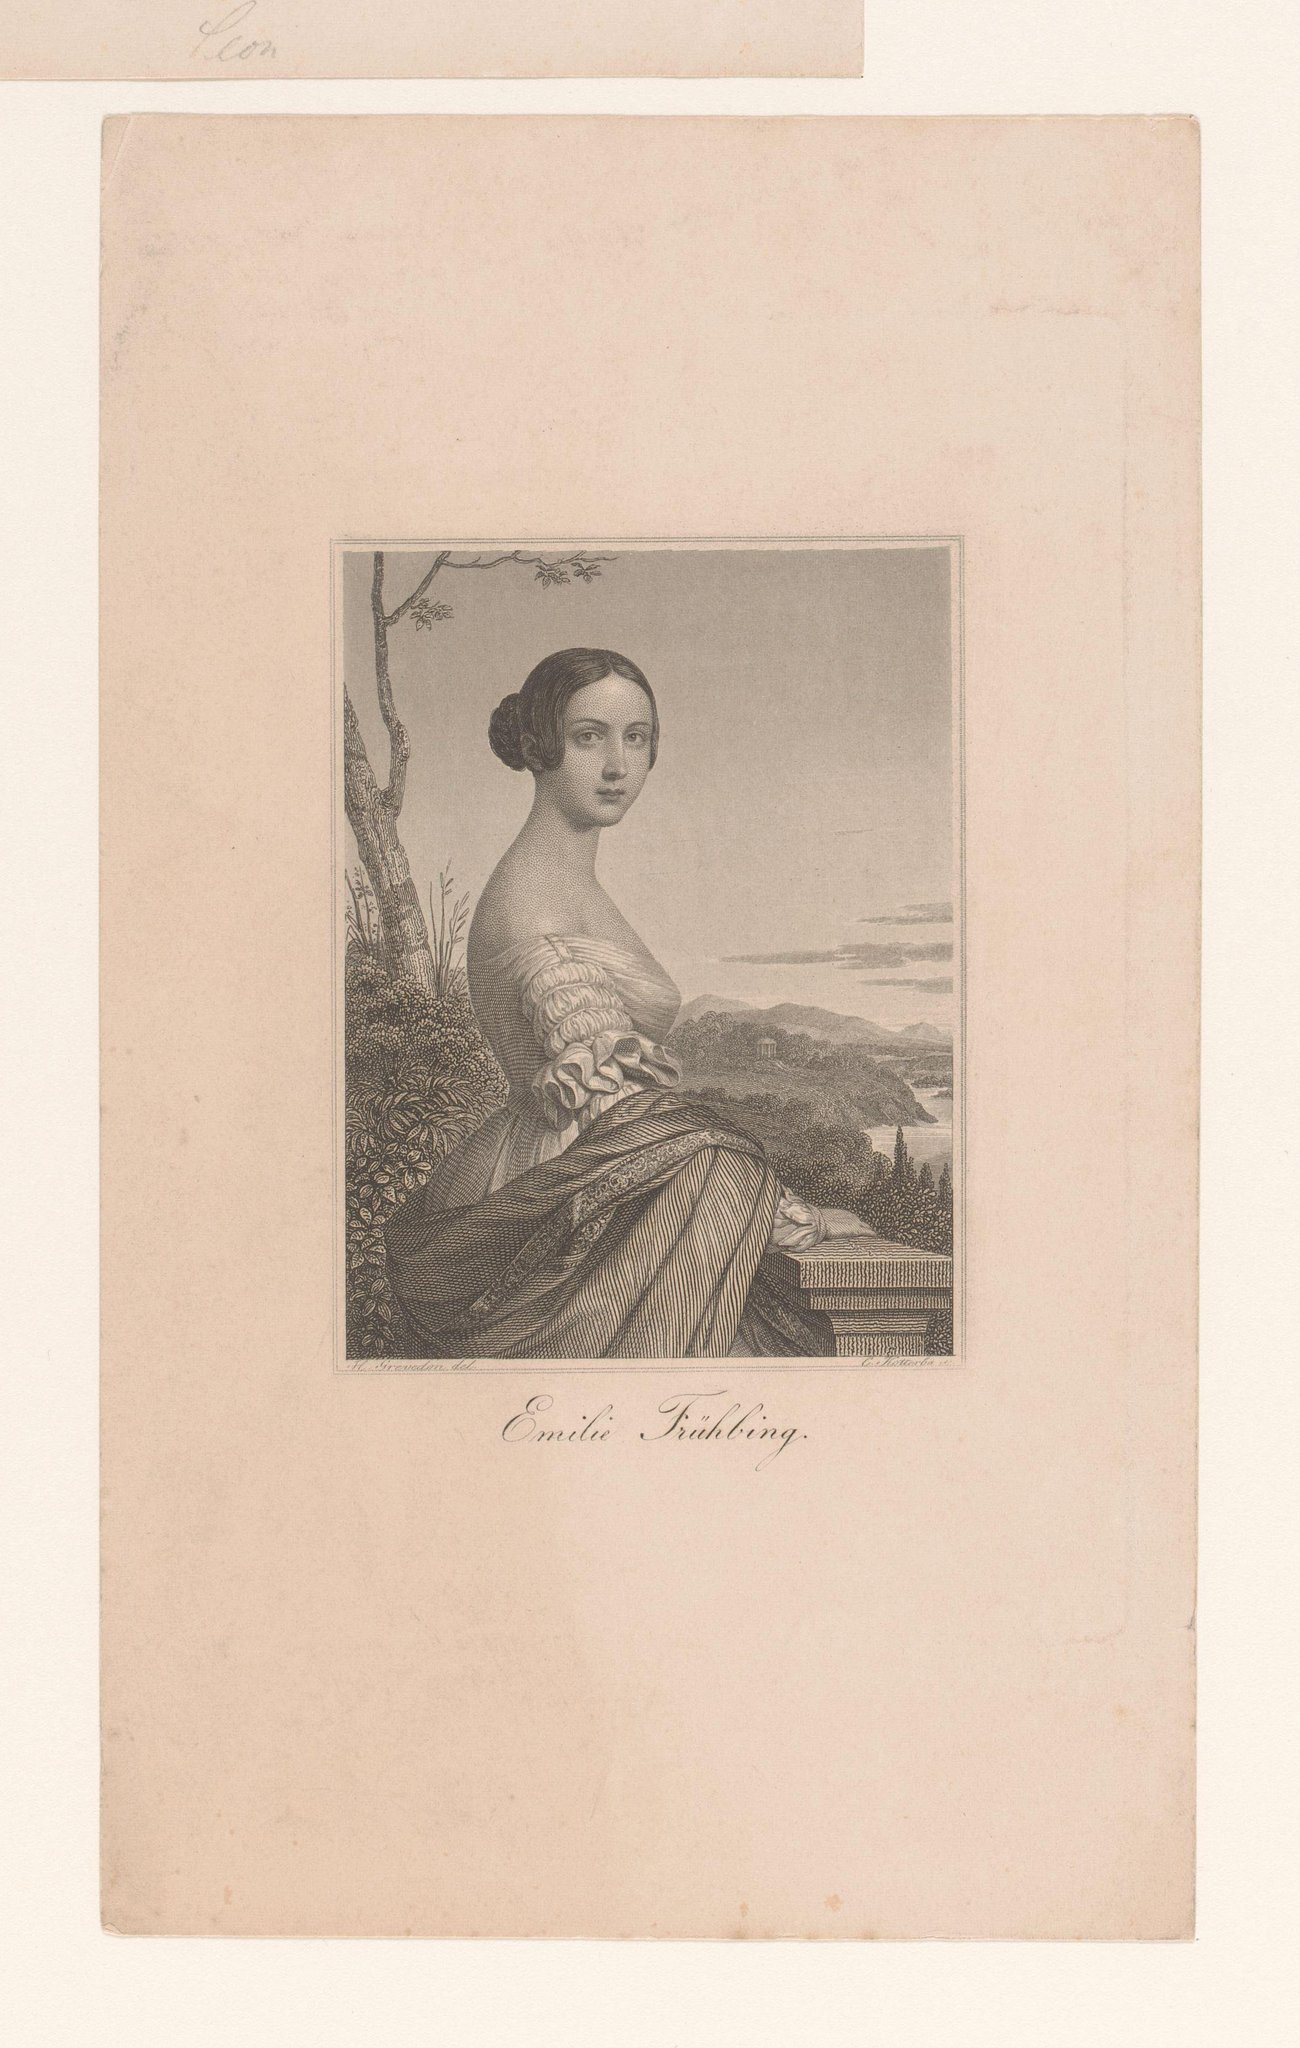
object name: print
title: Emilie Frühling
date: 1841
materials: paper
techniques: engraving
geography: vienna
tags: anonymous historical person portrayed alone - bb - woman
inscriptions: collector's mark: Lugt 2228